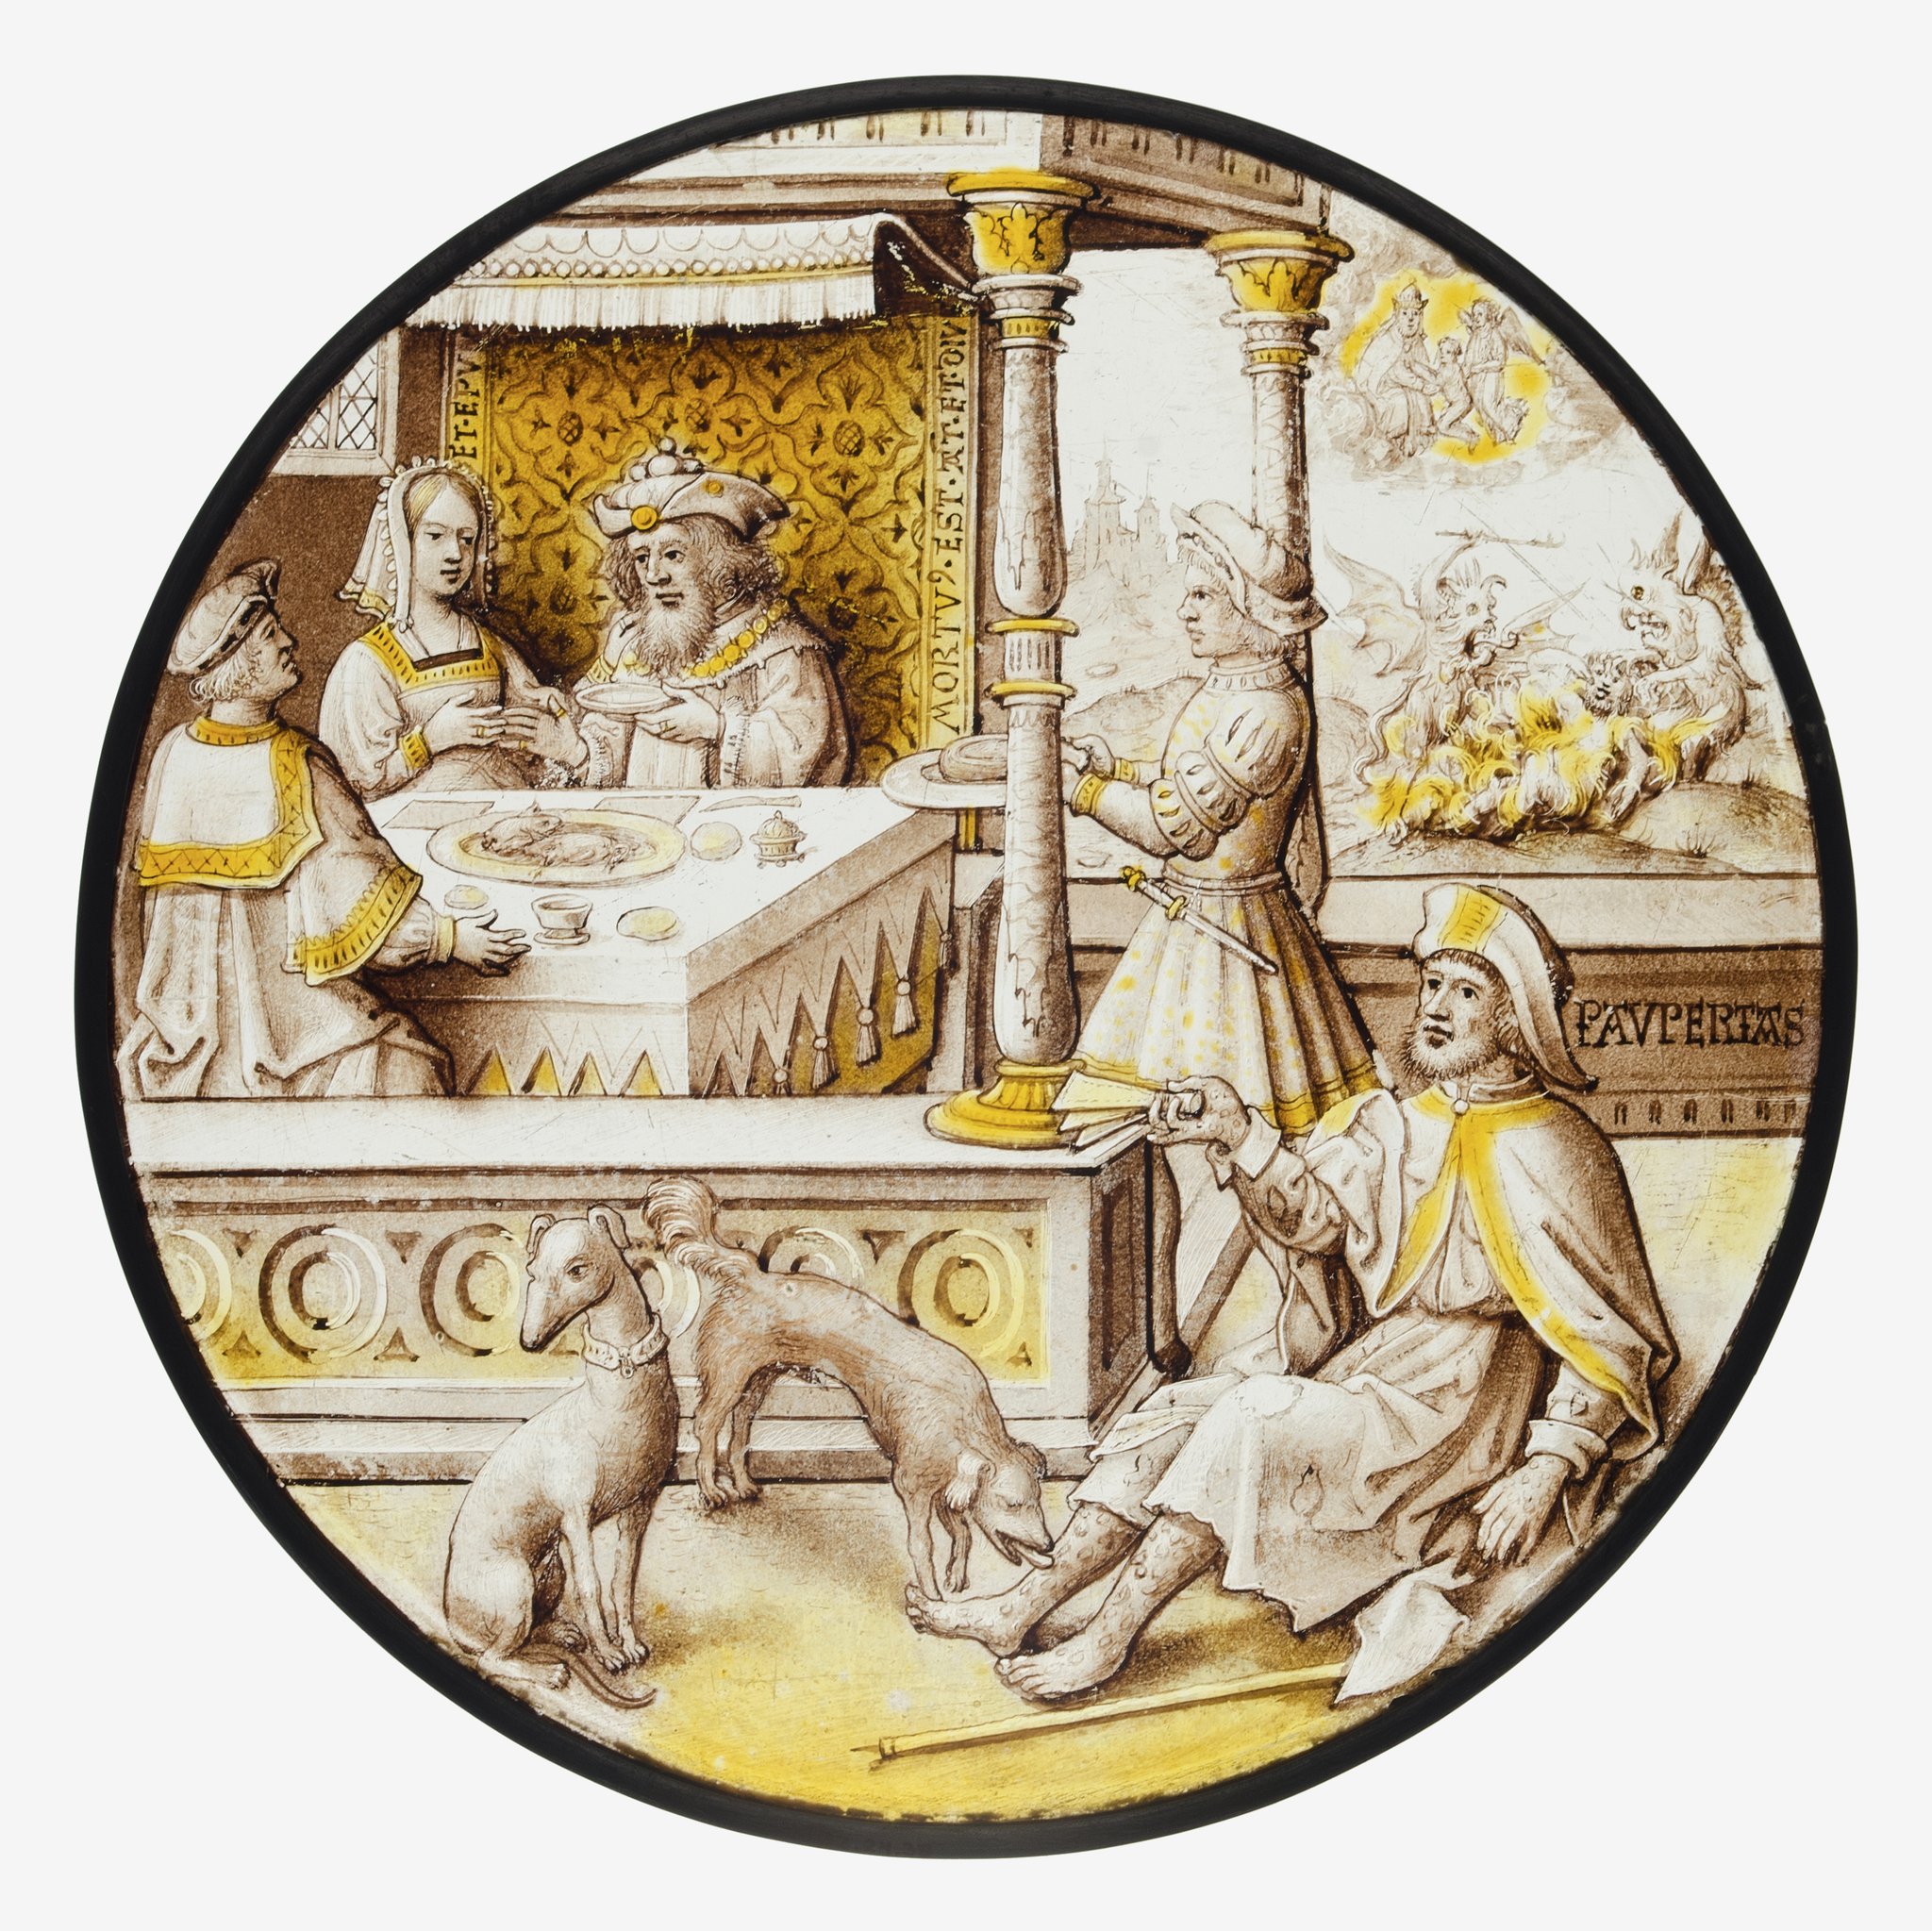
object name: roundel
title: Roundel with Lazarus at the House of Dives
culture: south netherlandish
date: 1520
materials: glass, paint, pigment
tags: food,men,women,dogs,demons,dining